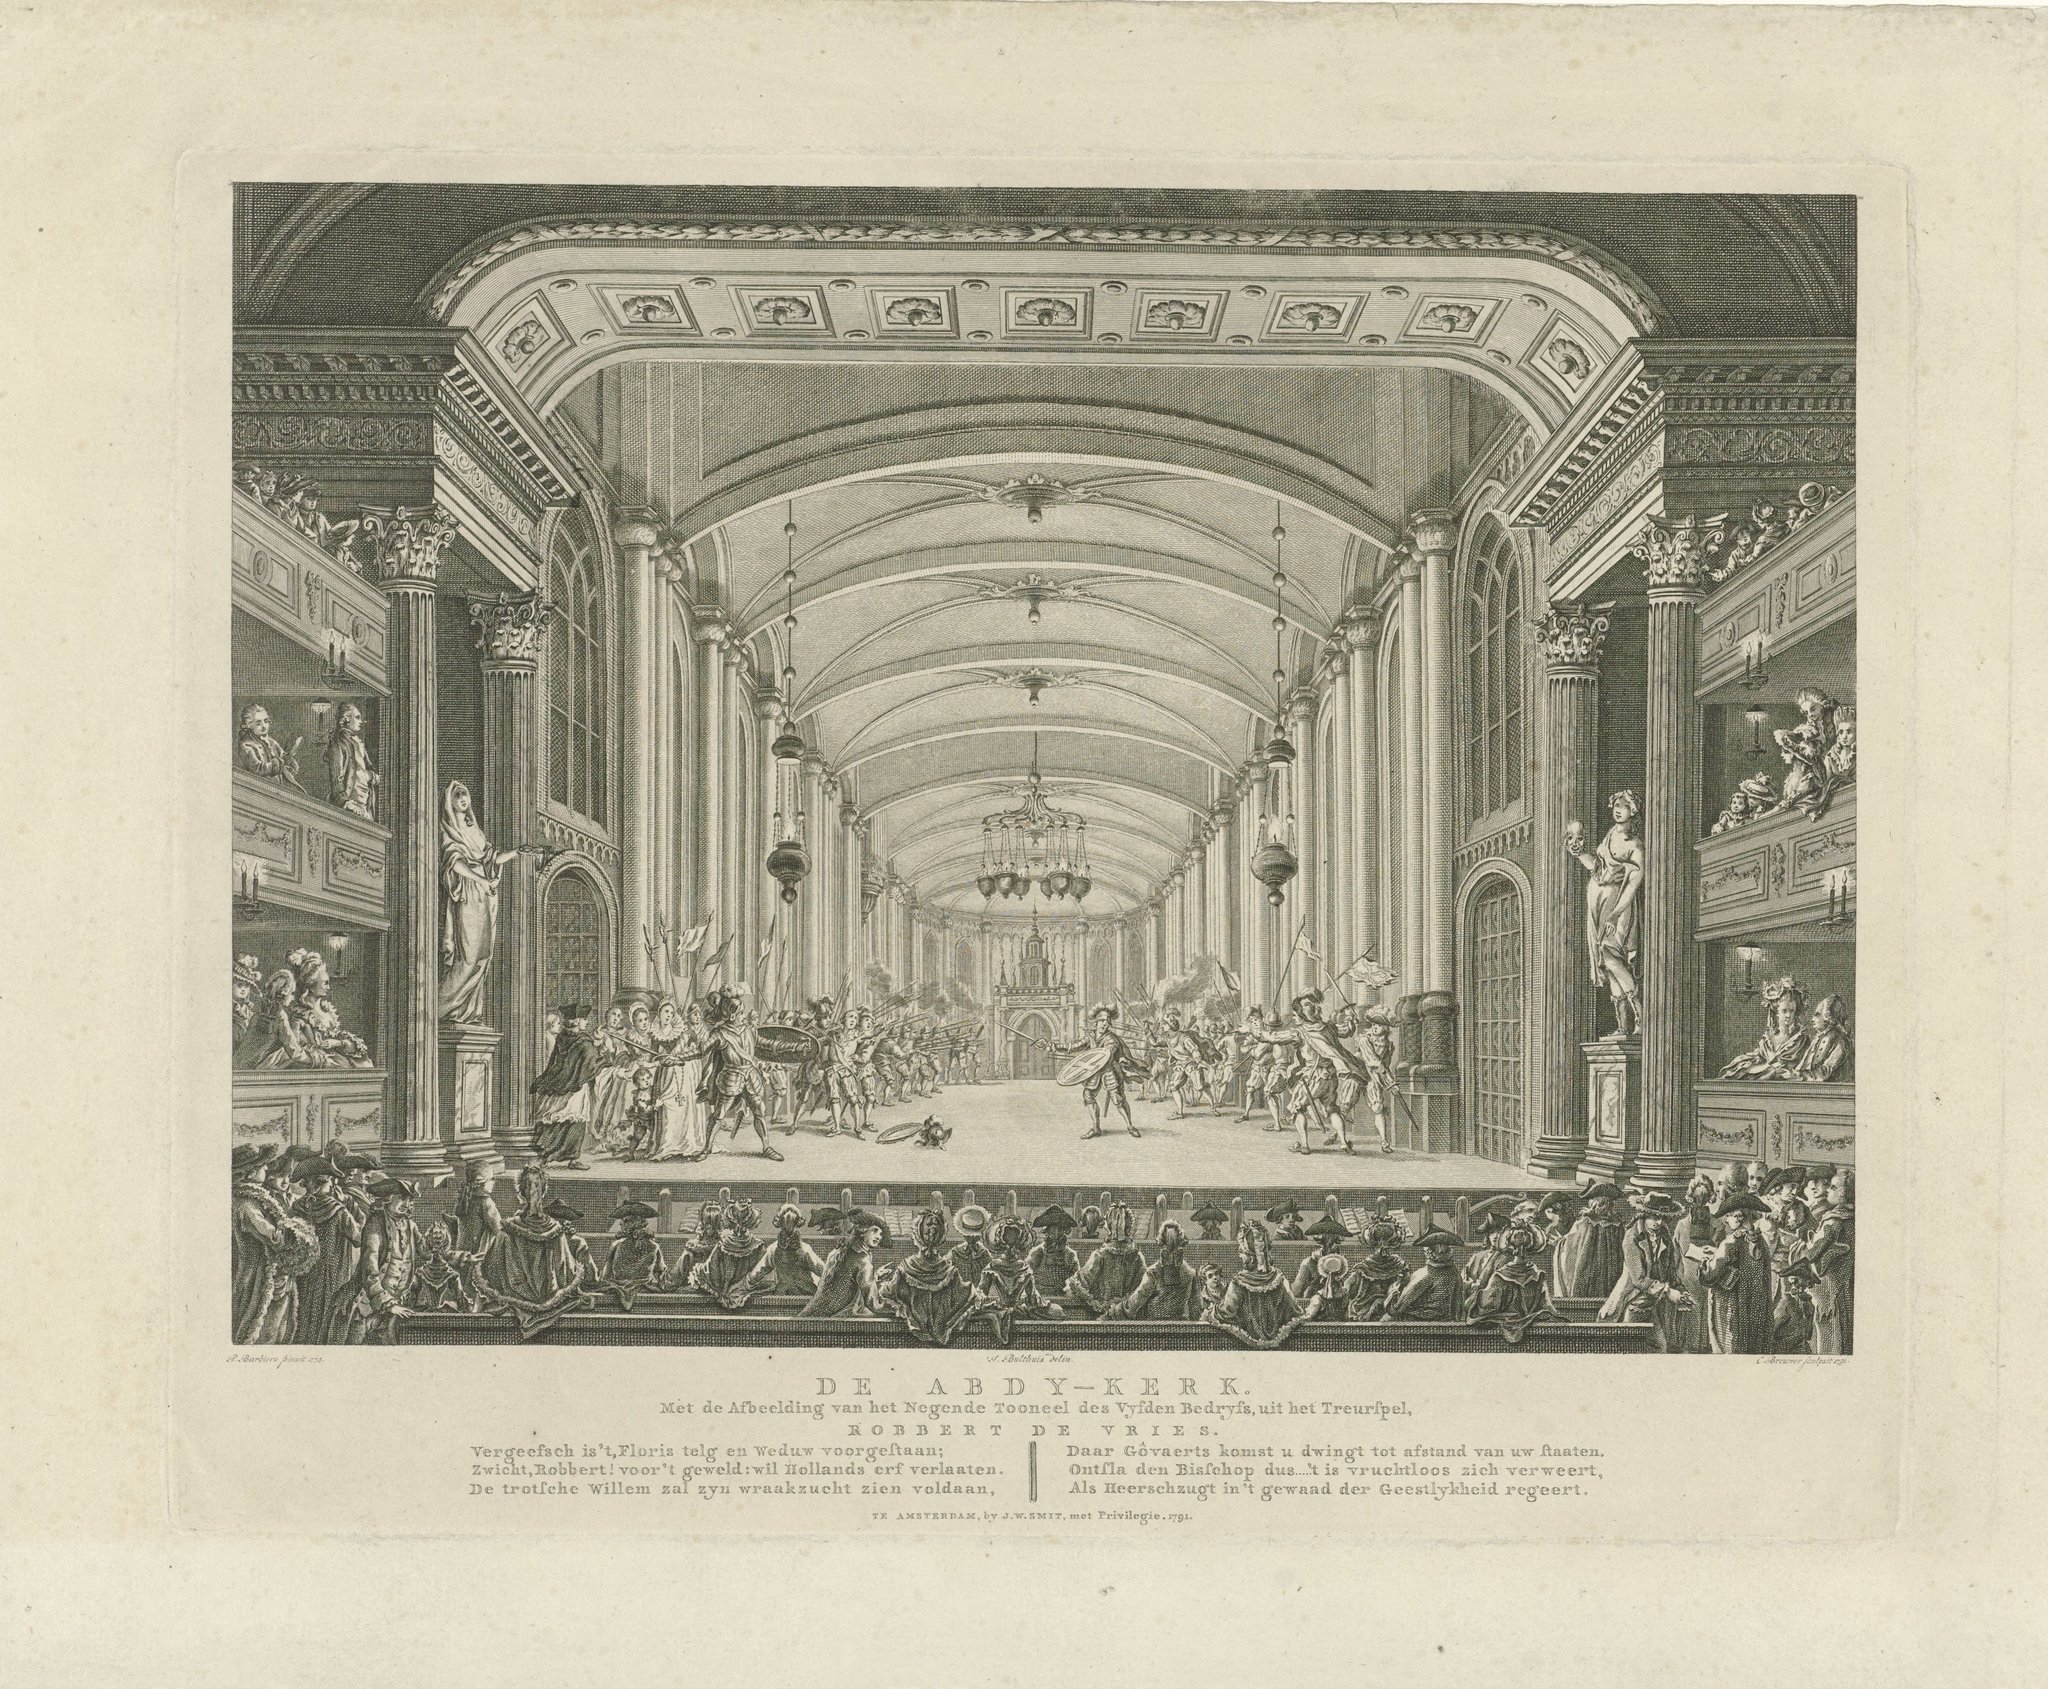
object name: print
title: Toneeldecors van de nieuwe Amsterdamse Schouwburg, 1787-1794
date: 1791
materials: paper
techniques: engraving, etching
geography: amsterdam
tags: theatre, theatrical performance, stage design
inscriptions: collector's mark: Lugt 2228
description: Toneelvoorstelling in de nieuwe Amsterdamse Schouwburg met het coulissendecor De Abdy-kerk met scène uit Robbert de Vries. Het decor gedrukt van een aparte plaat binnen een passe-partout met de zaal, zijloges, pilaren met standbeelden en de façade van het toneel. In het onderschrift een zesregelig vers. Onderdeel van de serie van veertien toneeldecors van de nieuwe Amsterdamse Schouwburg, 1787-1794.